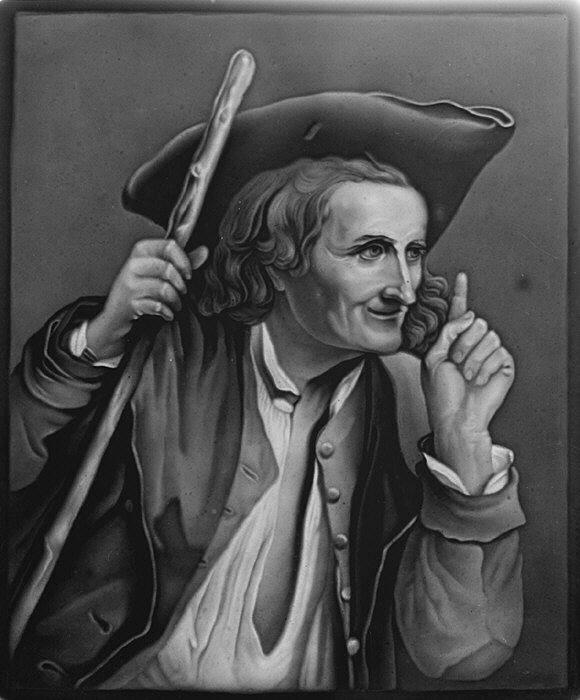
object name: lithophane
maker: royal porcelain manufactory, berlin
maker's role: manufactory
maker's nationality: german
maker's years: 1763-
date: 1834-1866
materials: porcelain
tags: men,portraits